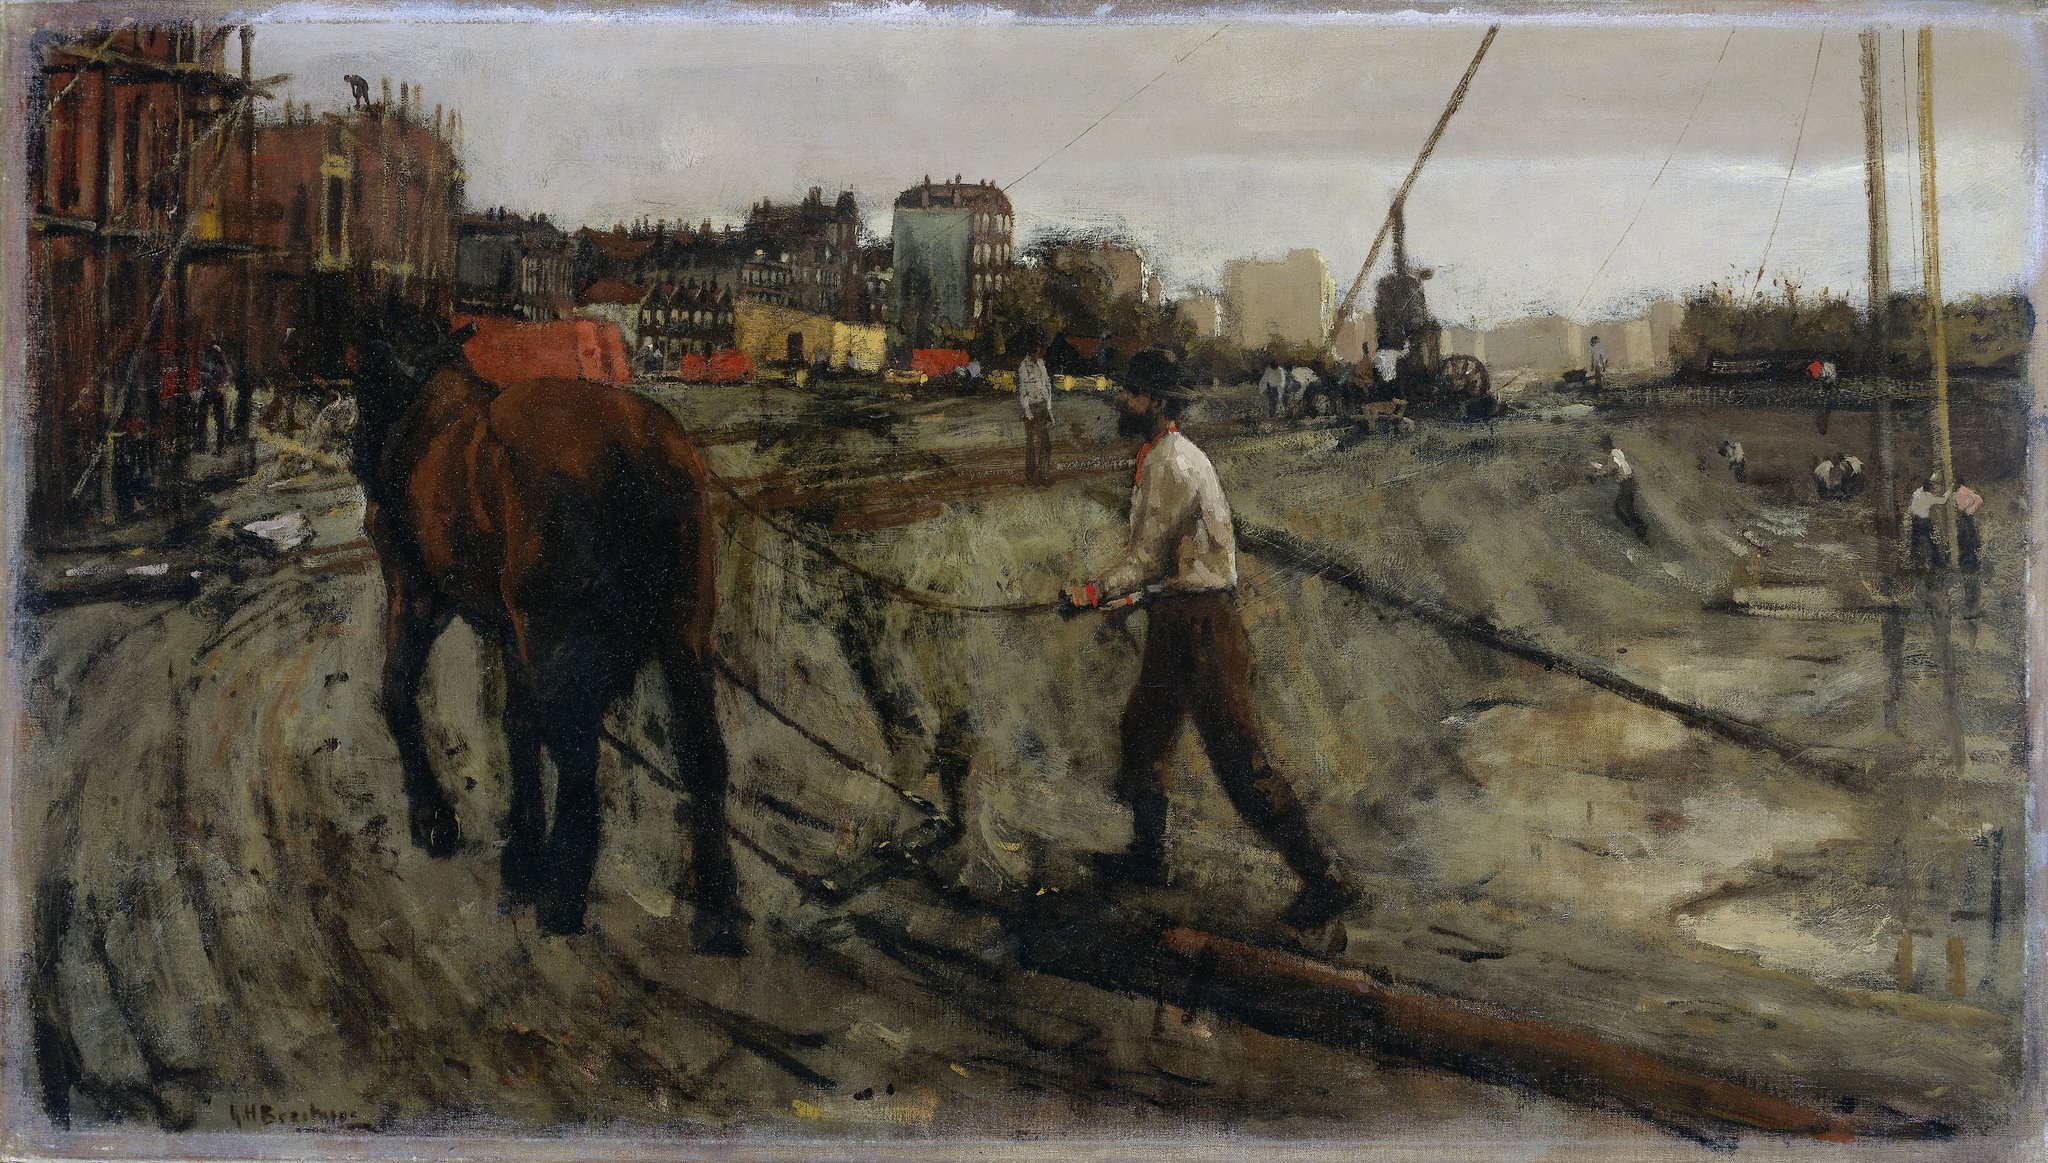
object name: painting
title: Building Site in Amsterdam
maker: george hendrik breitner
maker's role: draughtsman, painter, print maker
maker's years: 1857-1923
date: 1900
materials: canvas, oil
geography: amsterdam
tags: horse, building-site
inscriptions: signature: ‘G.H. Breitner’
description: Amsterdam underwent tremendous growth at the turn of the 20th century. The city expanded with new residential areas built on millions of piles. Breitner was fascinated by the modern metropolis and its many building sites. In this painting, we see new homes rising on the left, while a horse drags a pile into the construction pit in the foreground. On the right, another pile is driven into the ground with a steam hammer, a recent invention.